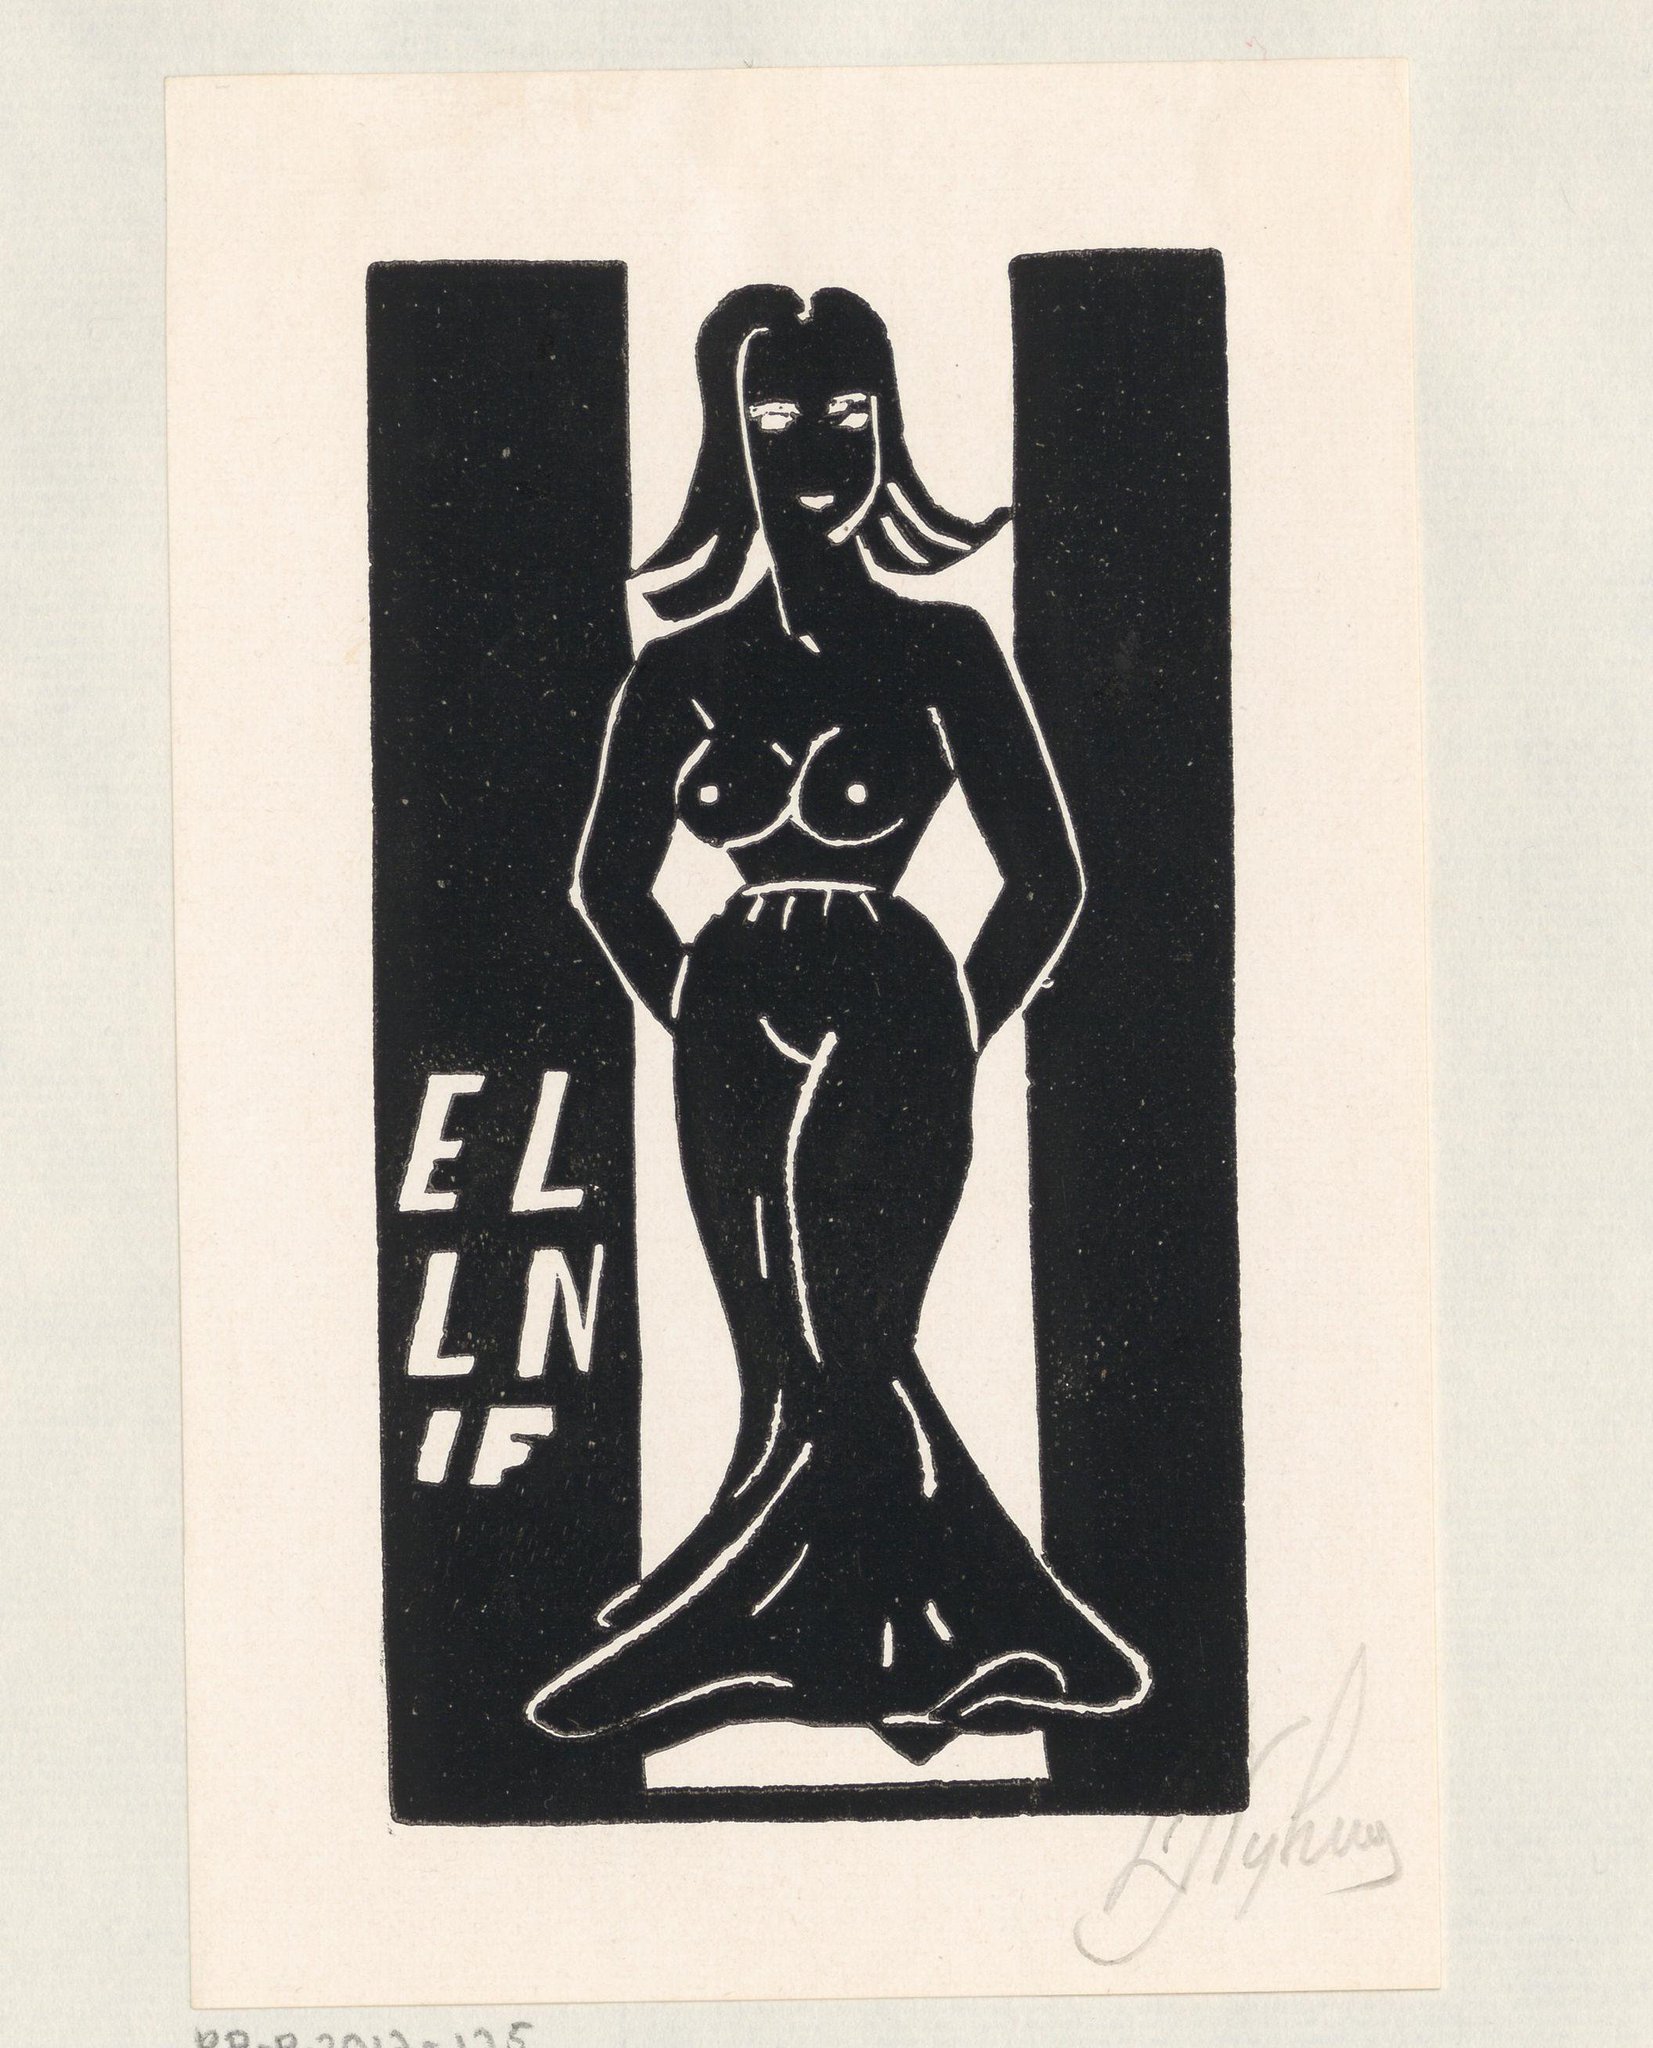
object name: bookplate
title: Ex libris van E.L.L.N.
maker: l. nijhuis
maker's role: print maker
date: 1956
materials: paper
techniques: linocut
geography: netherlands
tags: l. nijhuis, adult woman, woman (showing herself) undressed, quasi-nude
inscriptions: inscription: ‘Lino if. '56’, signature: ‘L Nyhuys’